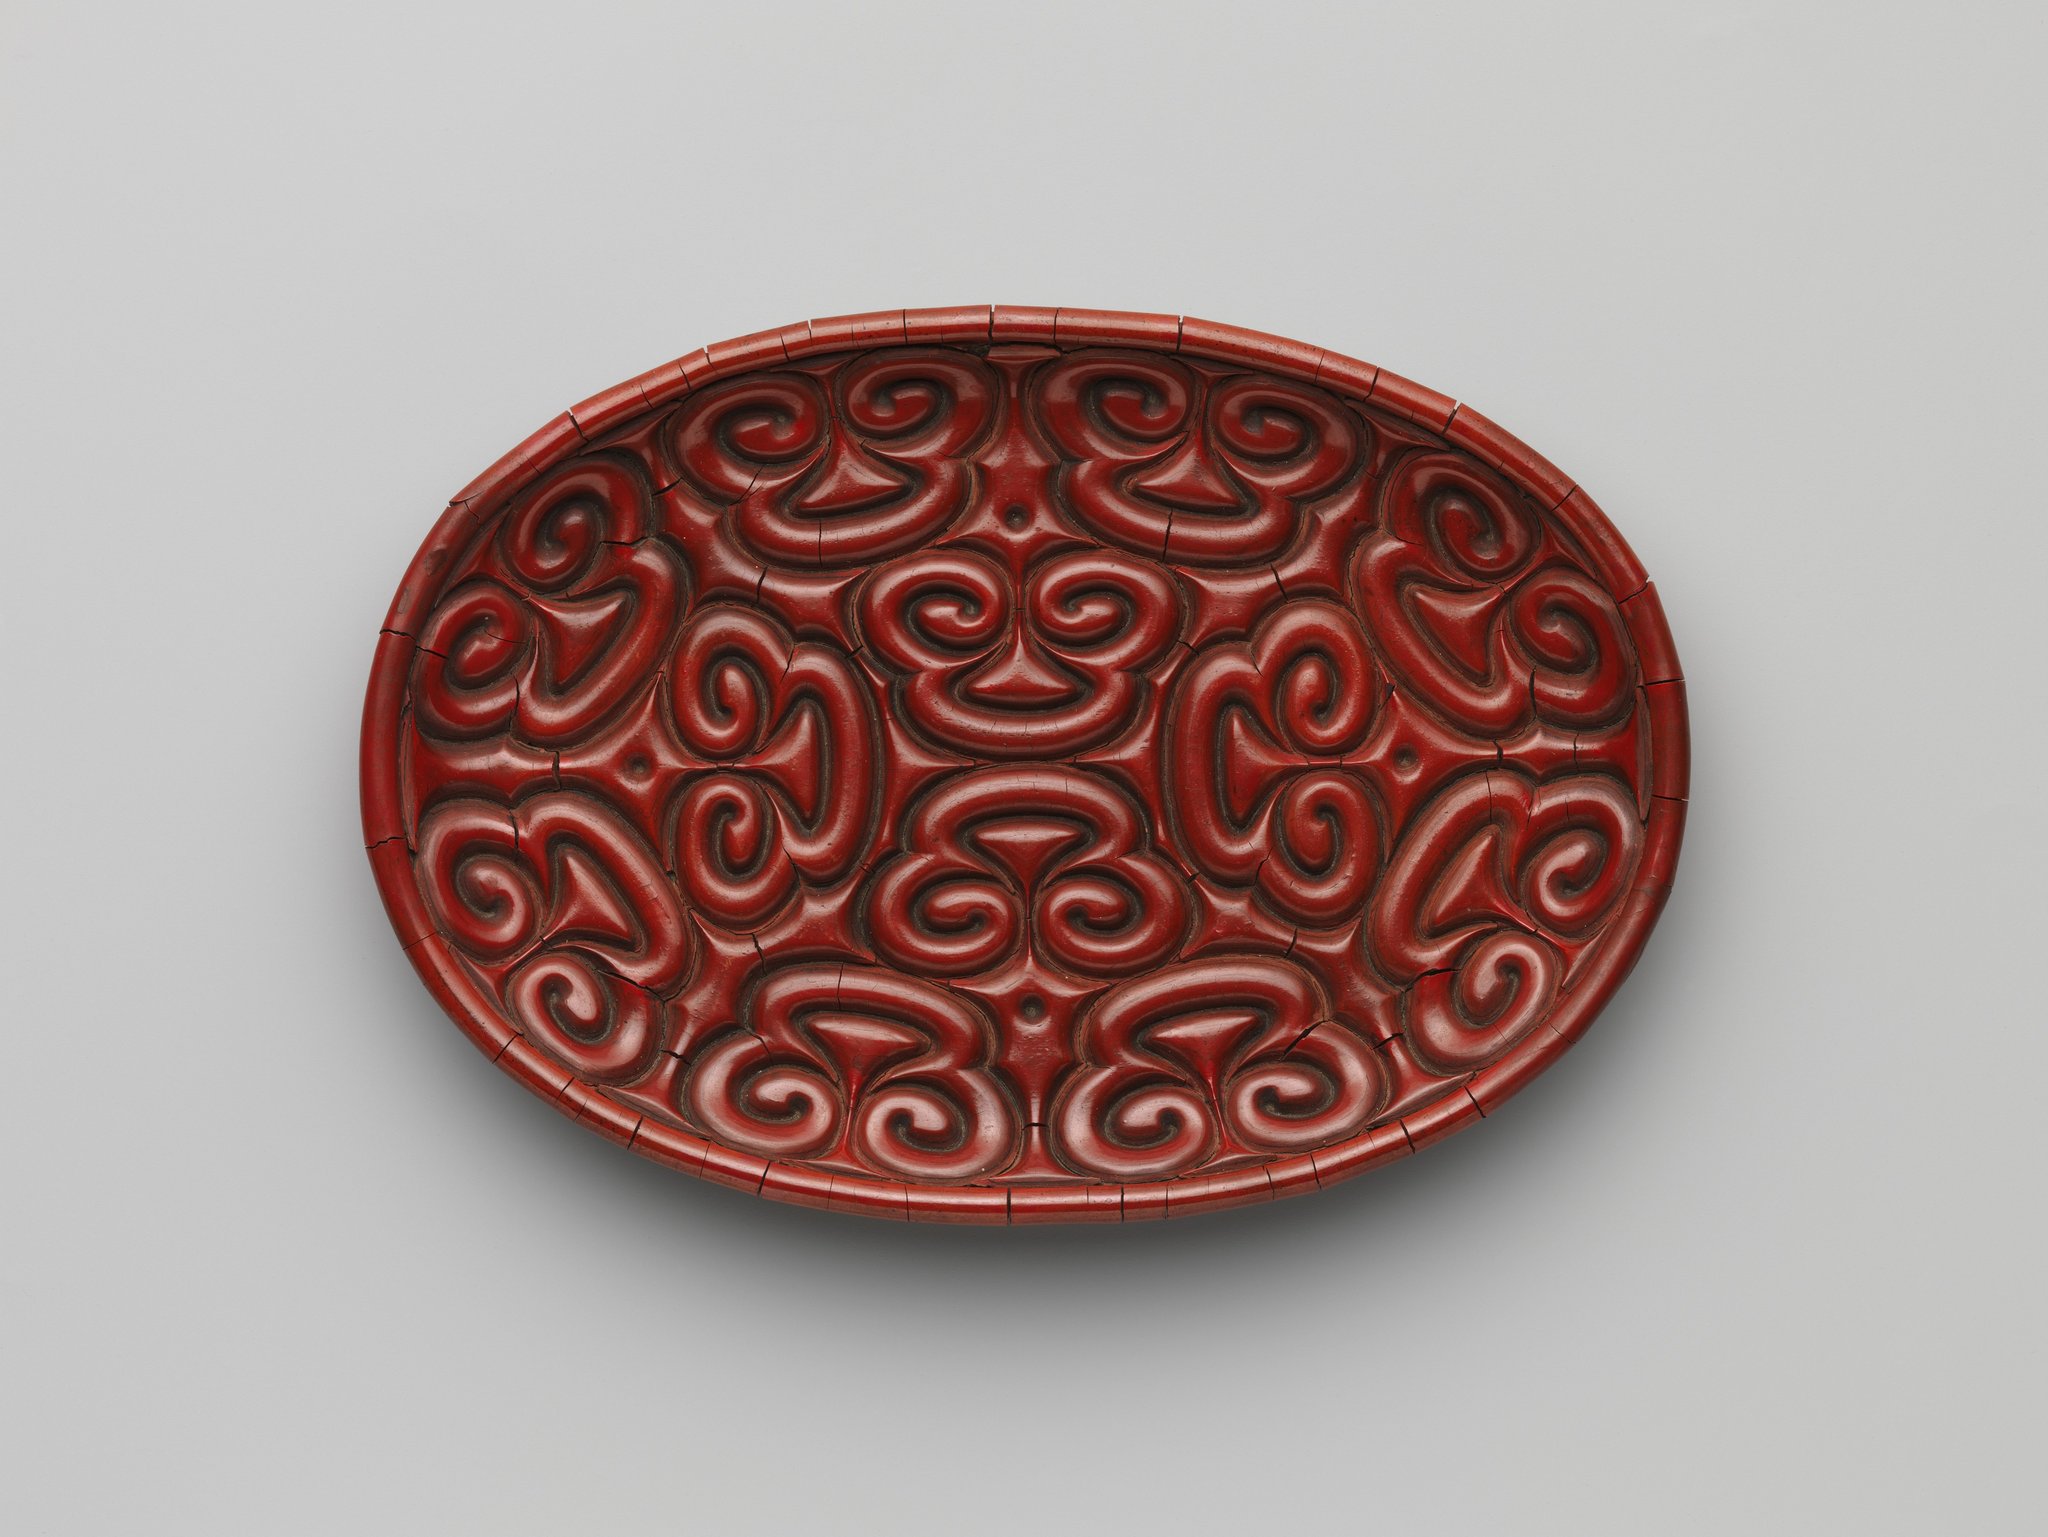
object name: tray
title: Tray with pommel scrolls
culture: chinese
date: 1301-1400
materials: lacquer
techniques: carving